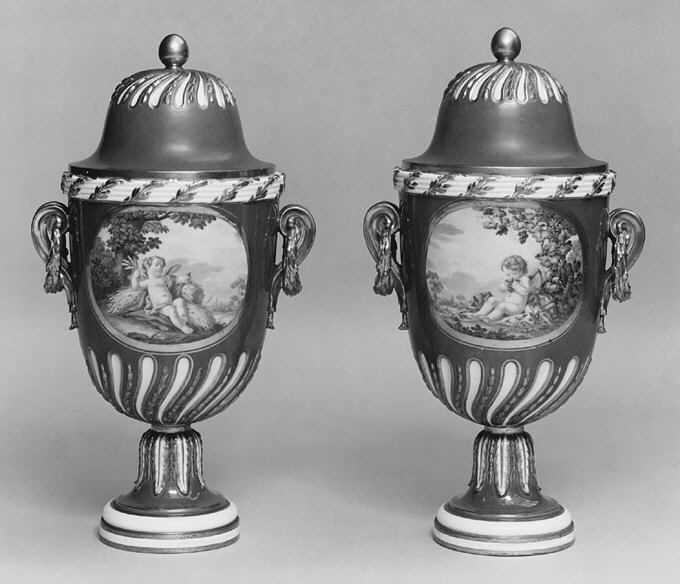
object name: vase with cover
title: Vase with cover (vase feuille de laurier) (one of a pair)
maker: sèvres manufactory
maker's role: manufactory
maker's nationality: french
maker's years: 1740-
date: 1770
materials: soft paste porcelain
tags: cupid